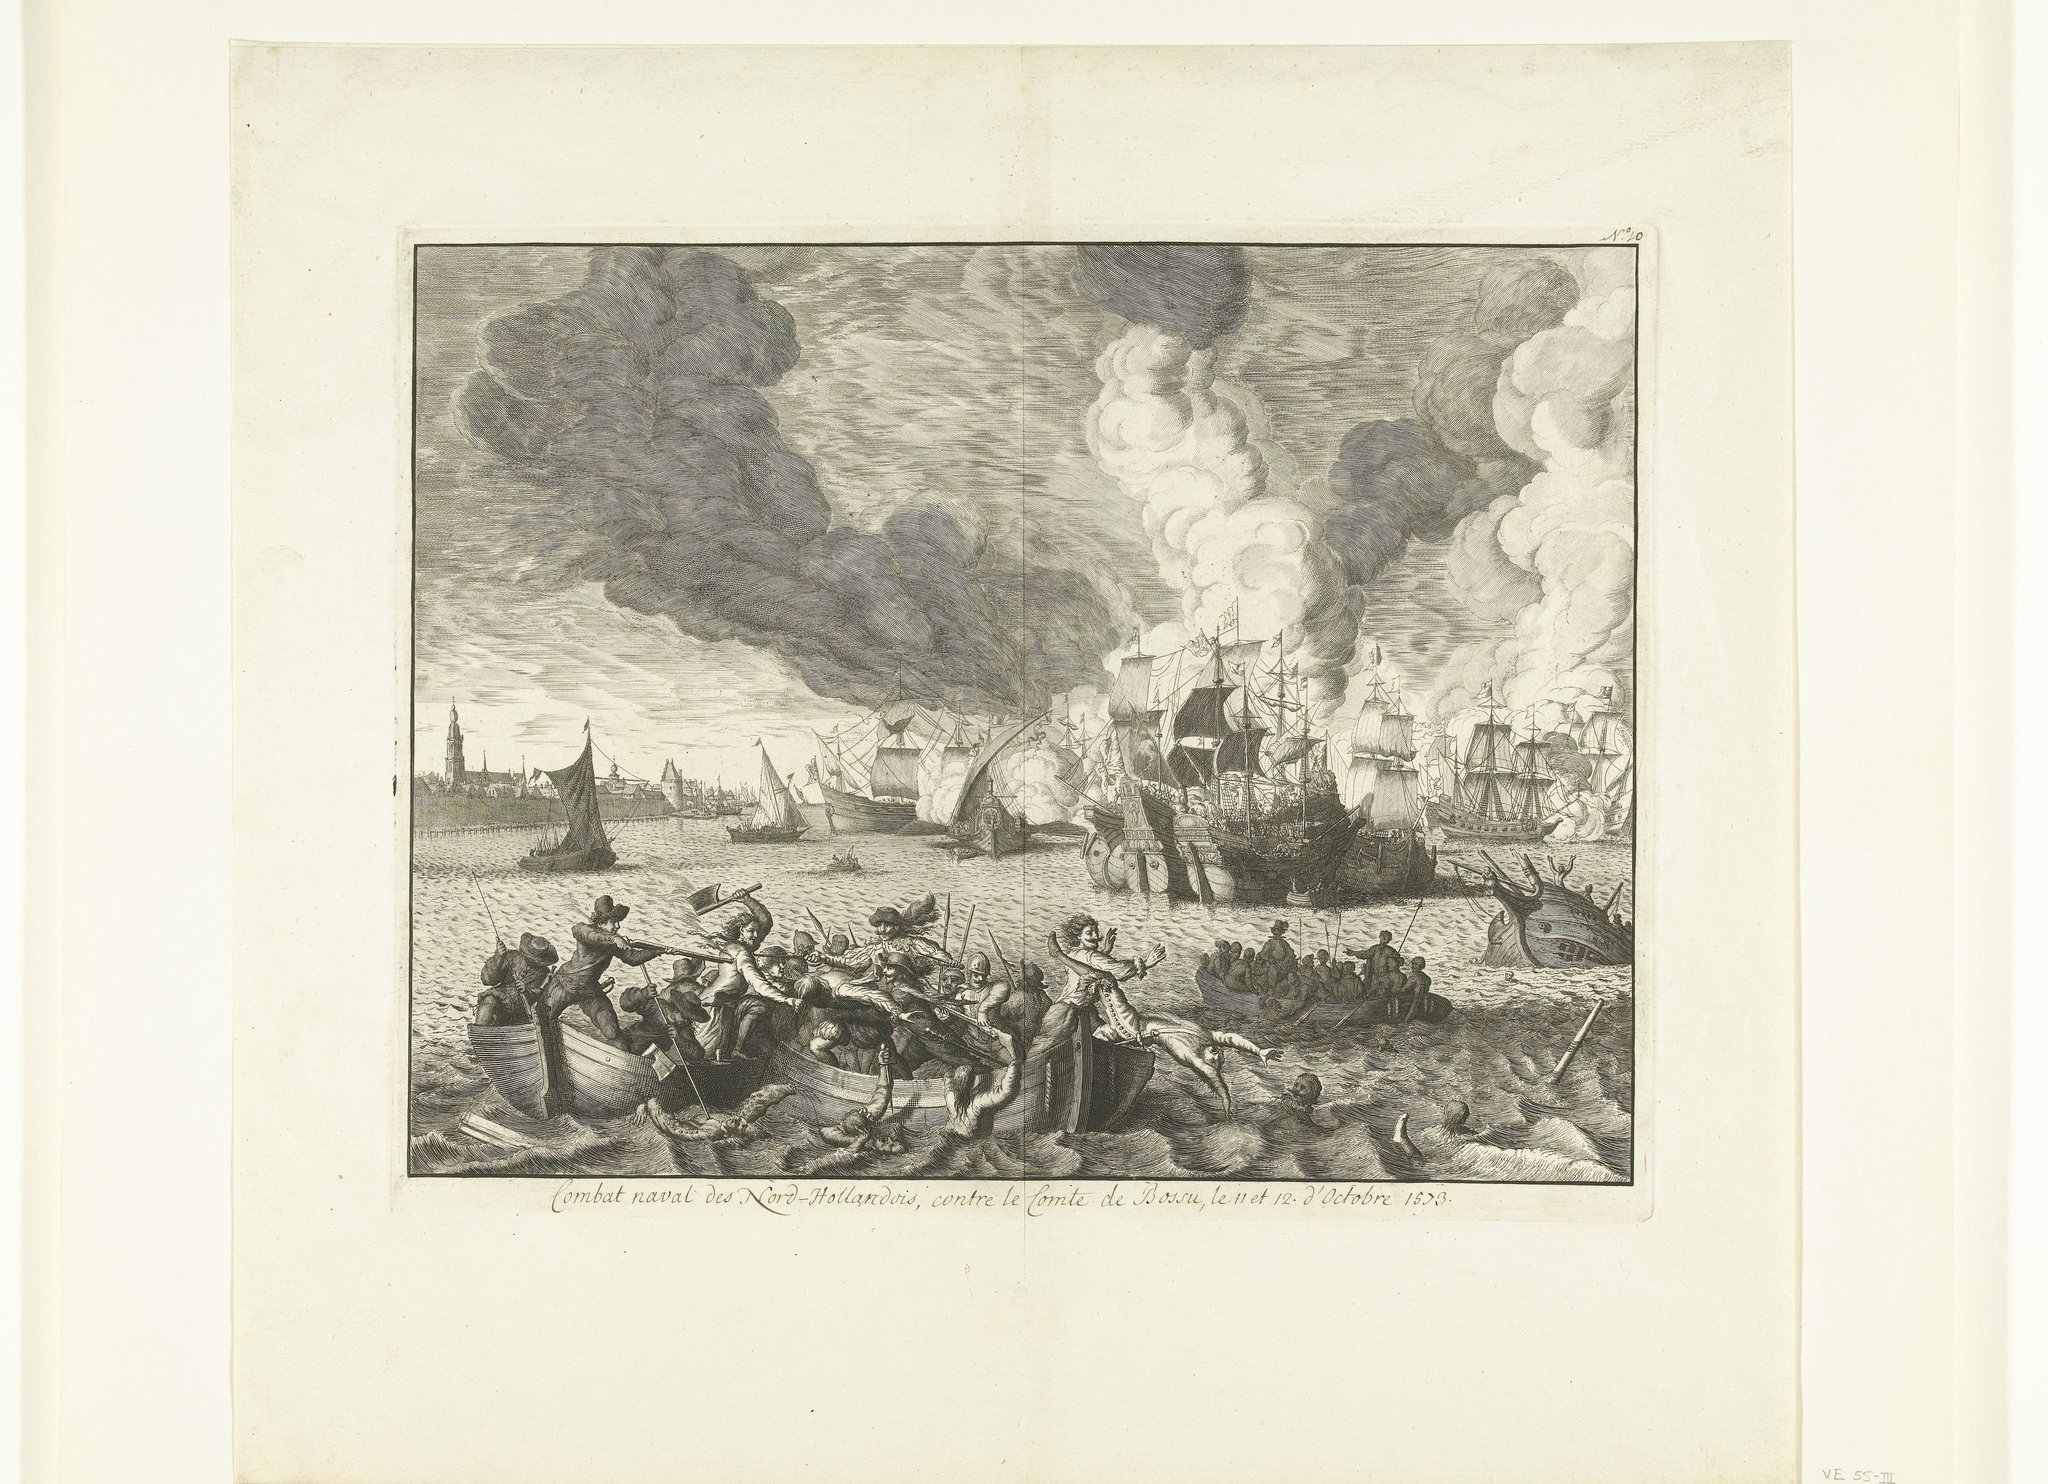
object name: history print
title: Slag op de Zuiderzee tegen de graaf van Bossu, 1573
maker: jan luyken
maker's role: draughtsman, print maker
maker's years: 1649-1712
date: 1677-1679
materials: paper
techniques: engraving, etching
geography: northern netherlands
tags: antwerp, earl, politician, battle (+ naval force), enkhuizen, zuiderzee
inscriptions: inscription: ‘Combat naval des Nord-Hollandois, contre le Comte de Bossu, le 11 et 12. d'Octobre 1573 / No. 10’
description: Deze staat ter voorbereiding voor gebruik als illustratie in: J. le Clerc, Geschiedenissen der Vereenigde Nederlanden, sedert den aanvang van die Republyk tot op den Vrede van Utrecht in 't jaar 1713 en het Tractaat van Barriere in 't jaar 1715 gesloten, Z. Chatelain, Amsterdam 1730, 3 delen. Staat vóór de letter, dl. I, pl. 10.